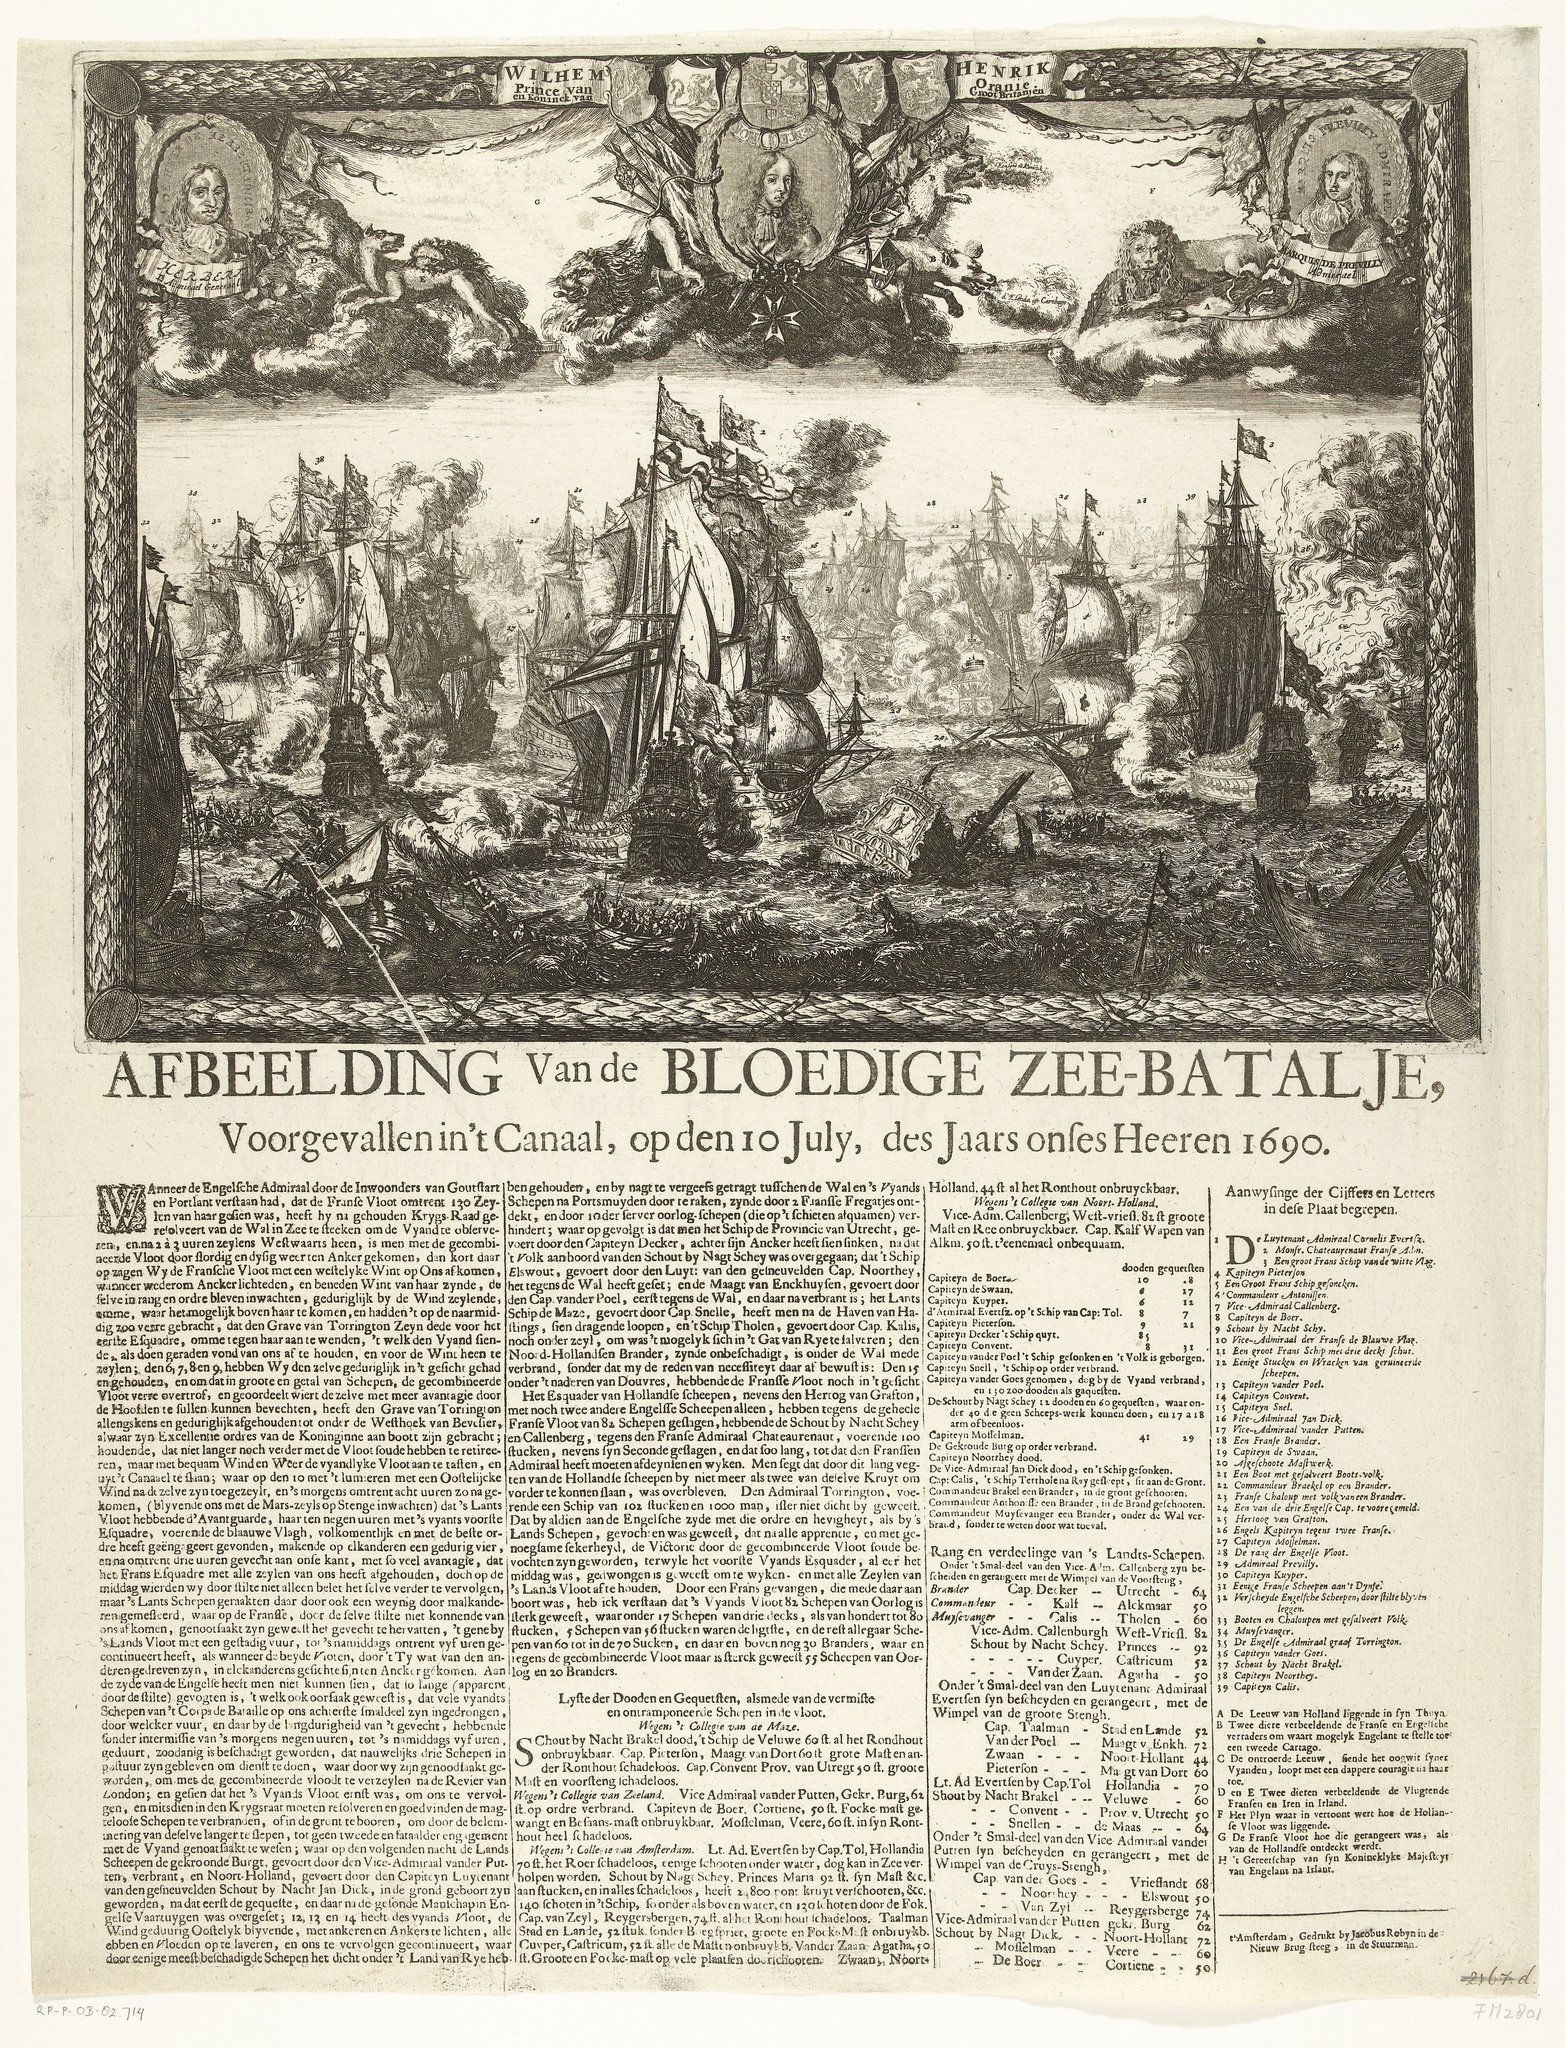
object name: print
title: Zeeslag bij Beachy Head, 1690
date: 1673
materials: paper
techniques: engraving, etching, letterpress printing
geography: amsterdam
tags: the hague, william iii (prince of orange and king of england, scotland, and ireland), paris, battle (+ naval force), battle of beachy head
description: Zeeslag bij Beachy Head (bij Béveziers) waarbij een gecombineerd Engelse en Nederlandse vloot verslagen wordt door de Fransen, 10 juli 1690. Bovenaan portretten van koning Willem III, links de Engelse admiraal lord Herbert en rechts de Franse admiraal. Op de prent wordt deze admiraal aangeduid als marquis de Previlly, waarschijnlijk betreft het de marquis de Châteaurenault, of Anne-Hilarion de Tourville. Op het blad onder de plaat in 4 kolommen een beschrijving en de legenda's 1-39 en A-H.